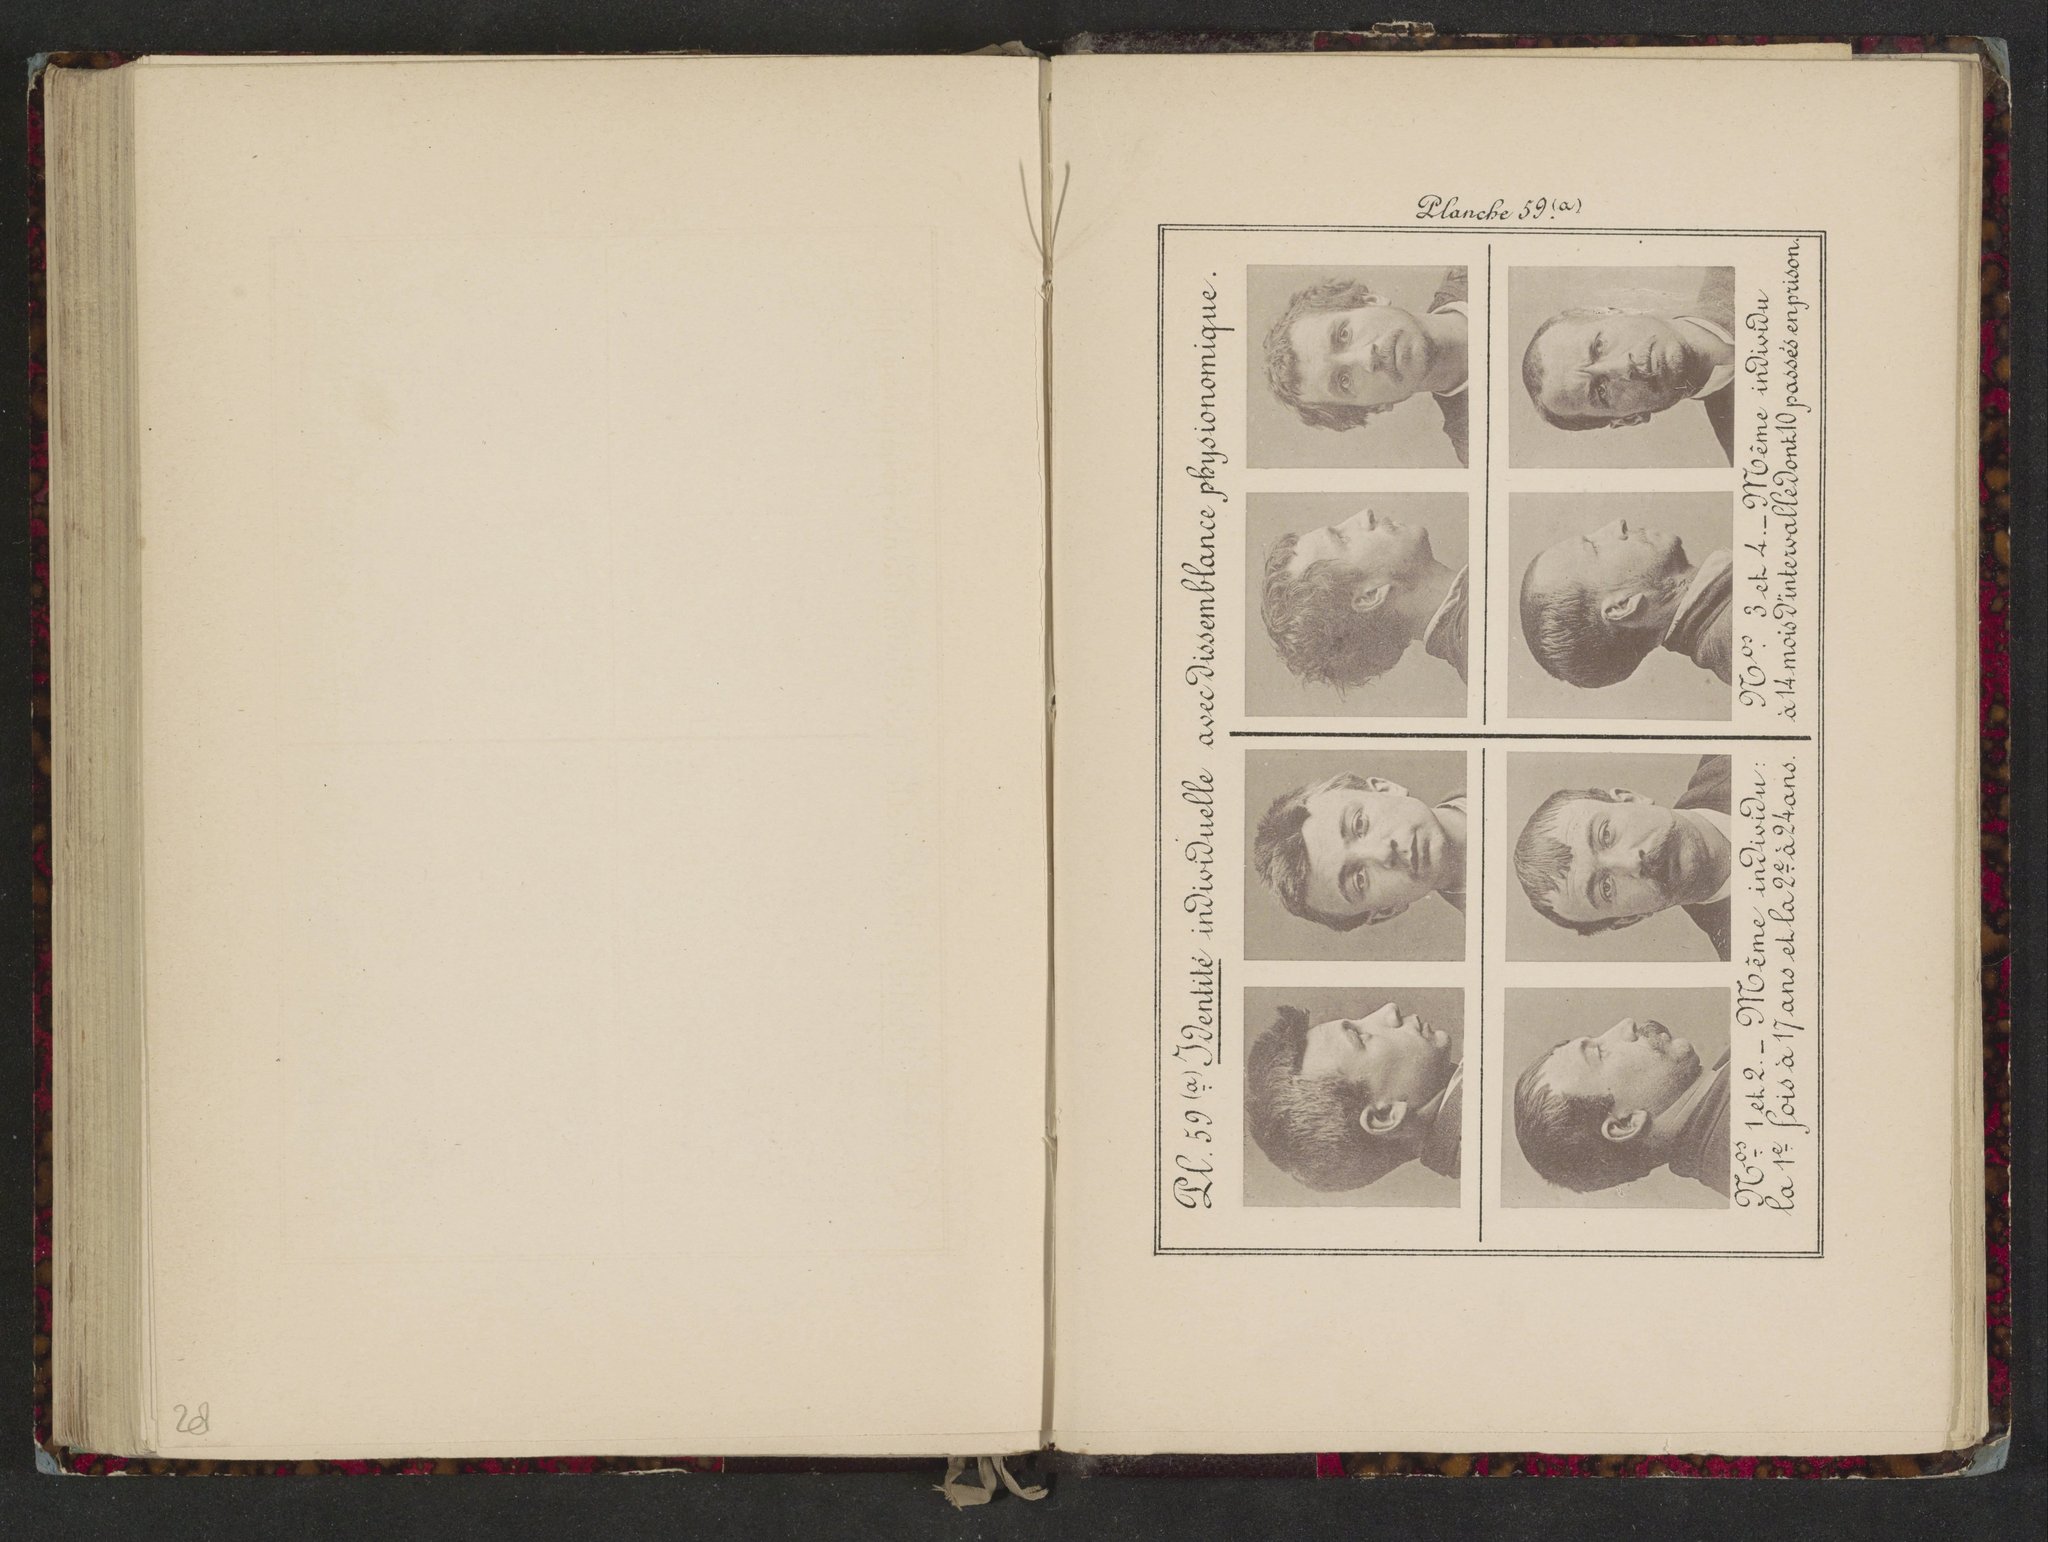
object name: photomechanical print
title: Acht afbeeldingen van twee mannen, genomen op twee leeftijden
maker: Anonymous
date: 1880-1893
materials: paper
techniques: photograph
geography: france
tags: head (human) (+ front view), head (human) (+ sideview, profile), criminals, france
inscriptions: number: ‘Planche 59. (a)’, inscription: ‘Même individu à 14 mois d'intervalle dont 10 passé en prison.’, inscription: ‘Même individu : la 1e fois à 17 ans et la 2e à 24 ans.’, number: ‘Nos. 1 et 2.’, number: ‘Nos. 3 et 4.’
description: De vier afbeeldingen links zijn van een man op 17-jarige en 24-jarige leeftijd, de vier rechts zijn van een man, gemaakt met veertien maanden tussenpose.